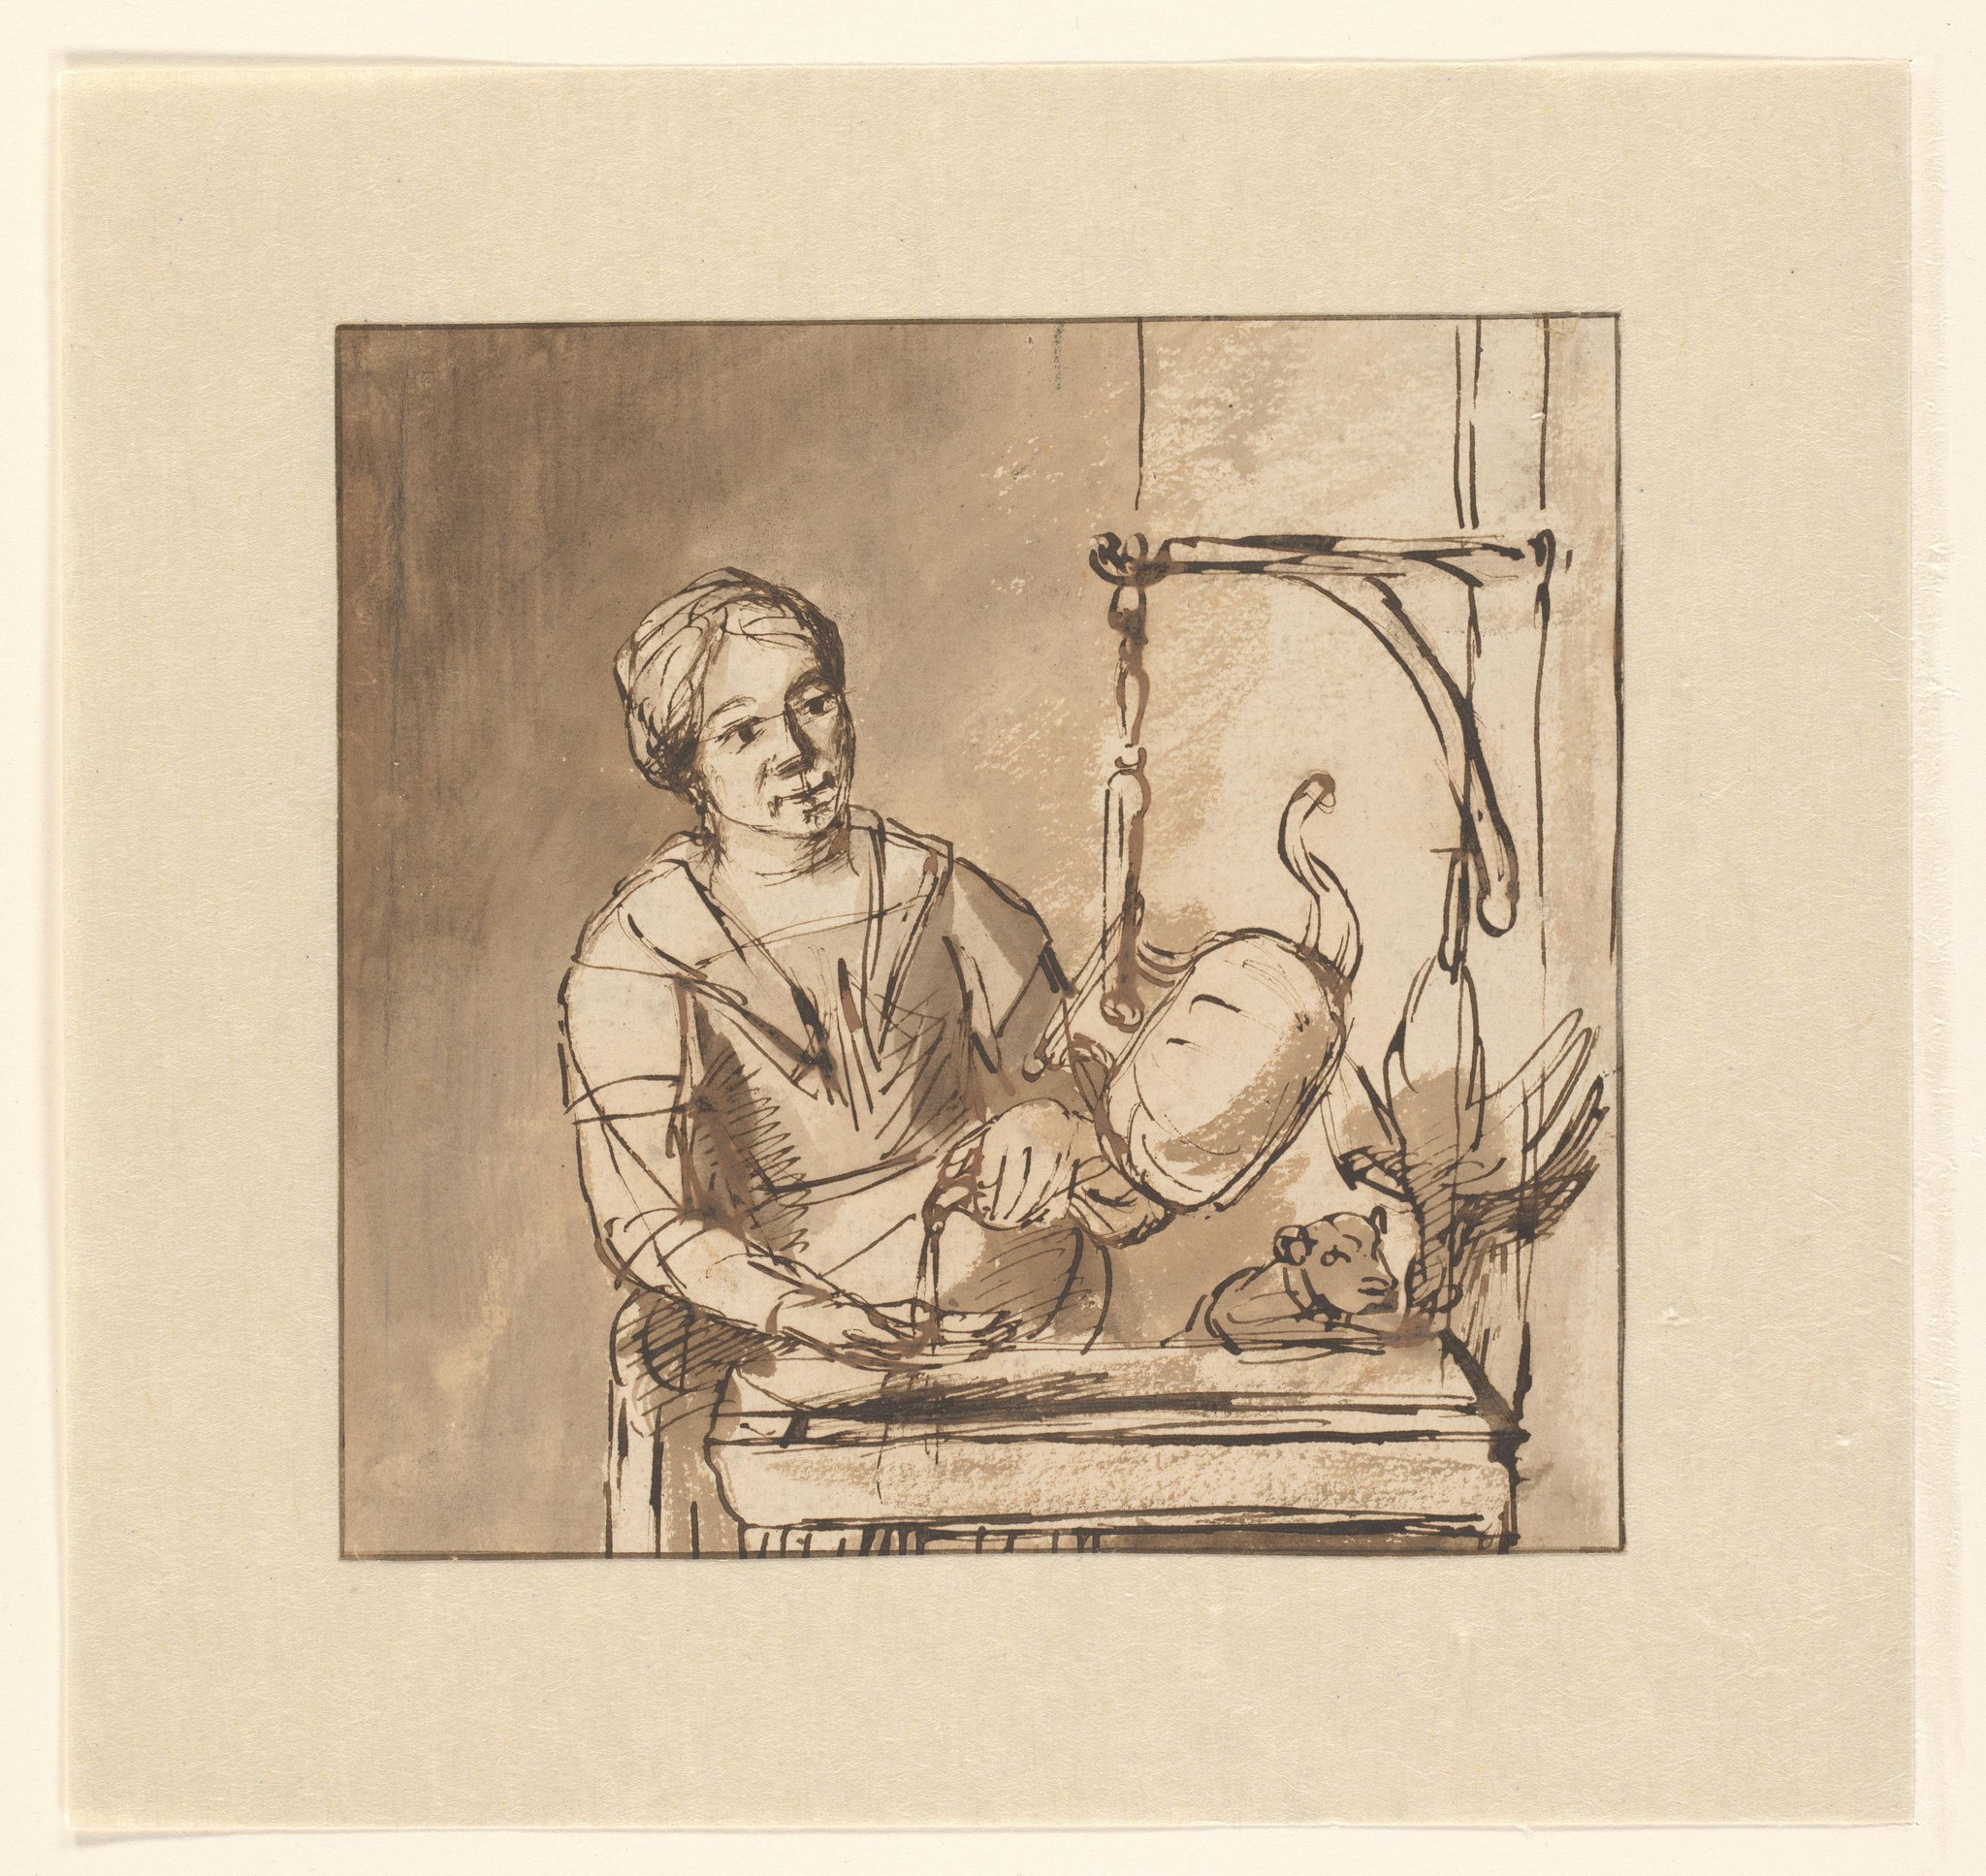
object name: drawing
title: De keukenmeid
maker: nicolaes maes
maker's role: draughtsman, painter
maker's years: 1634-1693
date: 1644-1693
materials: ink, paper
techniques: brush, pen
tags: standing figure - aa - female human figure, kitchen-maid, kitchen servant